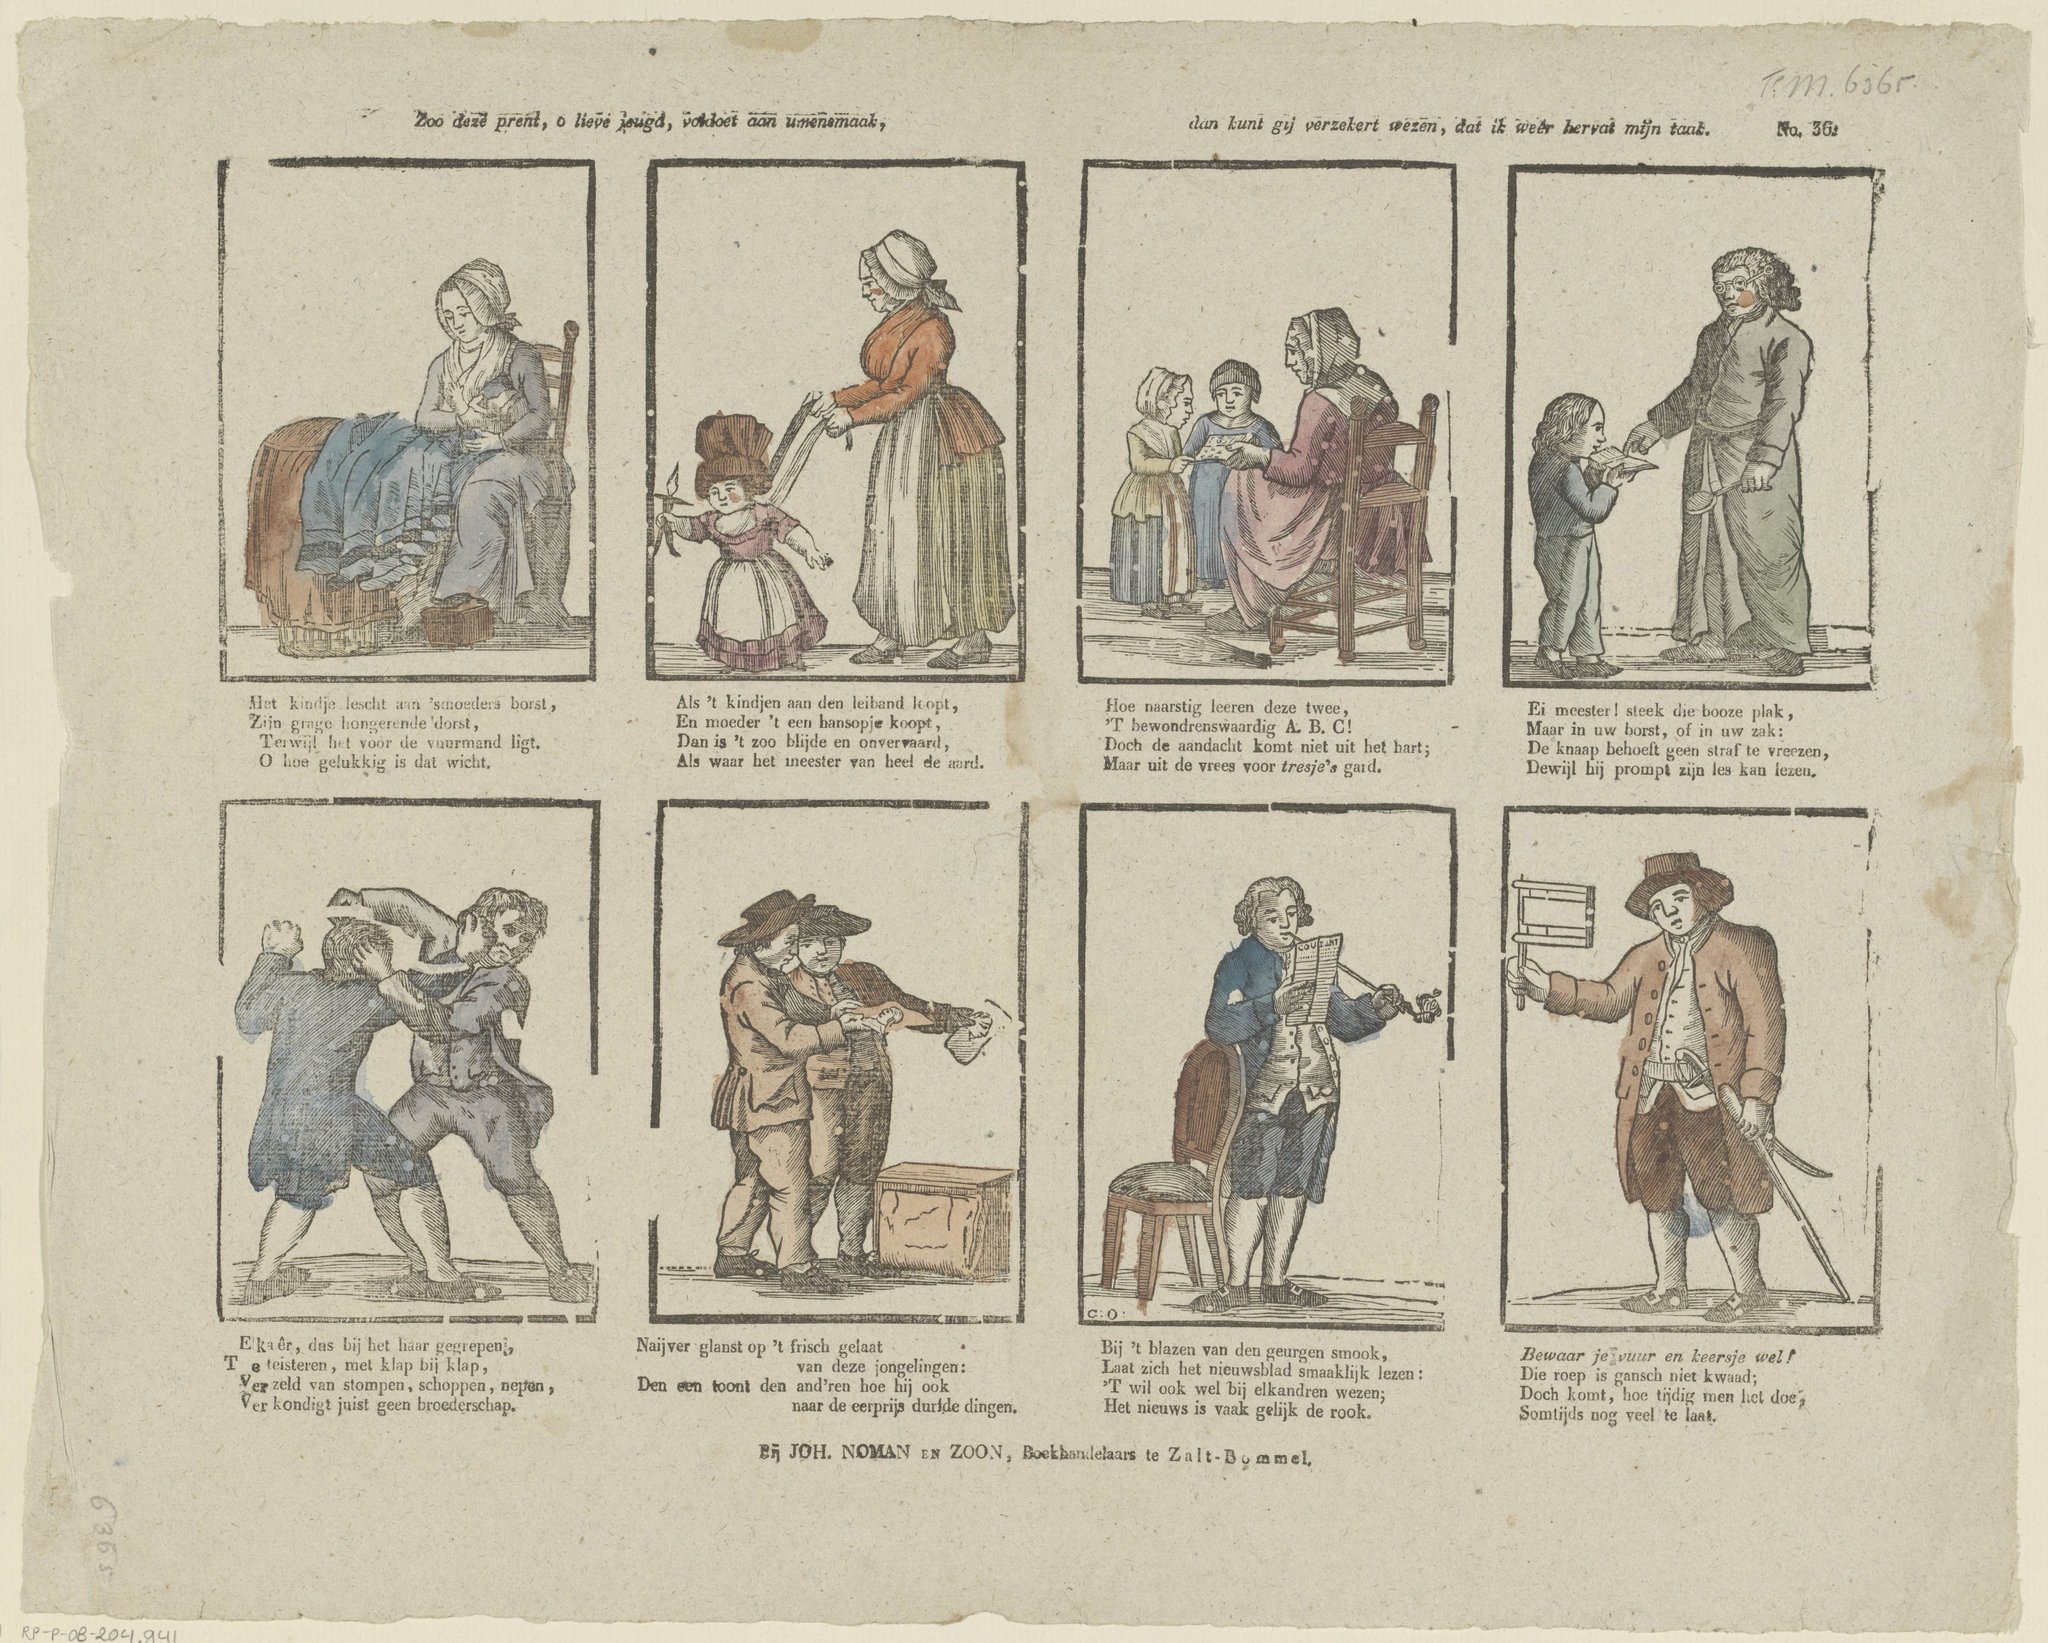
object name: print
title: Zoo deze prent, o lieve jeugd, voldoet aan uwensmaak, / dan kunt gij verzekert wezen, dat ik weer hervat mijn taak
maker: gerrit oortman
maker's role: print maker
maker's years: 1781-1822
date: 1830-1892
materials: paper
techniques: colour, letterpress printing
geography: netherlands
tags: human types, pipe ~ tobacco, mother and baby or young child, fighting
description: Blad met 8 voorstellingen van verschillende figuren en bezigheden. Onder elke afbeelding een vierregelig vers Genummerd rechtsboven: No. 36.